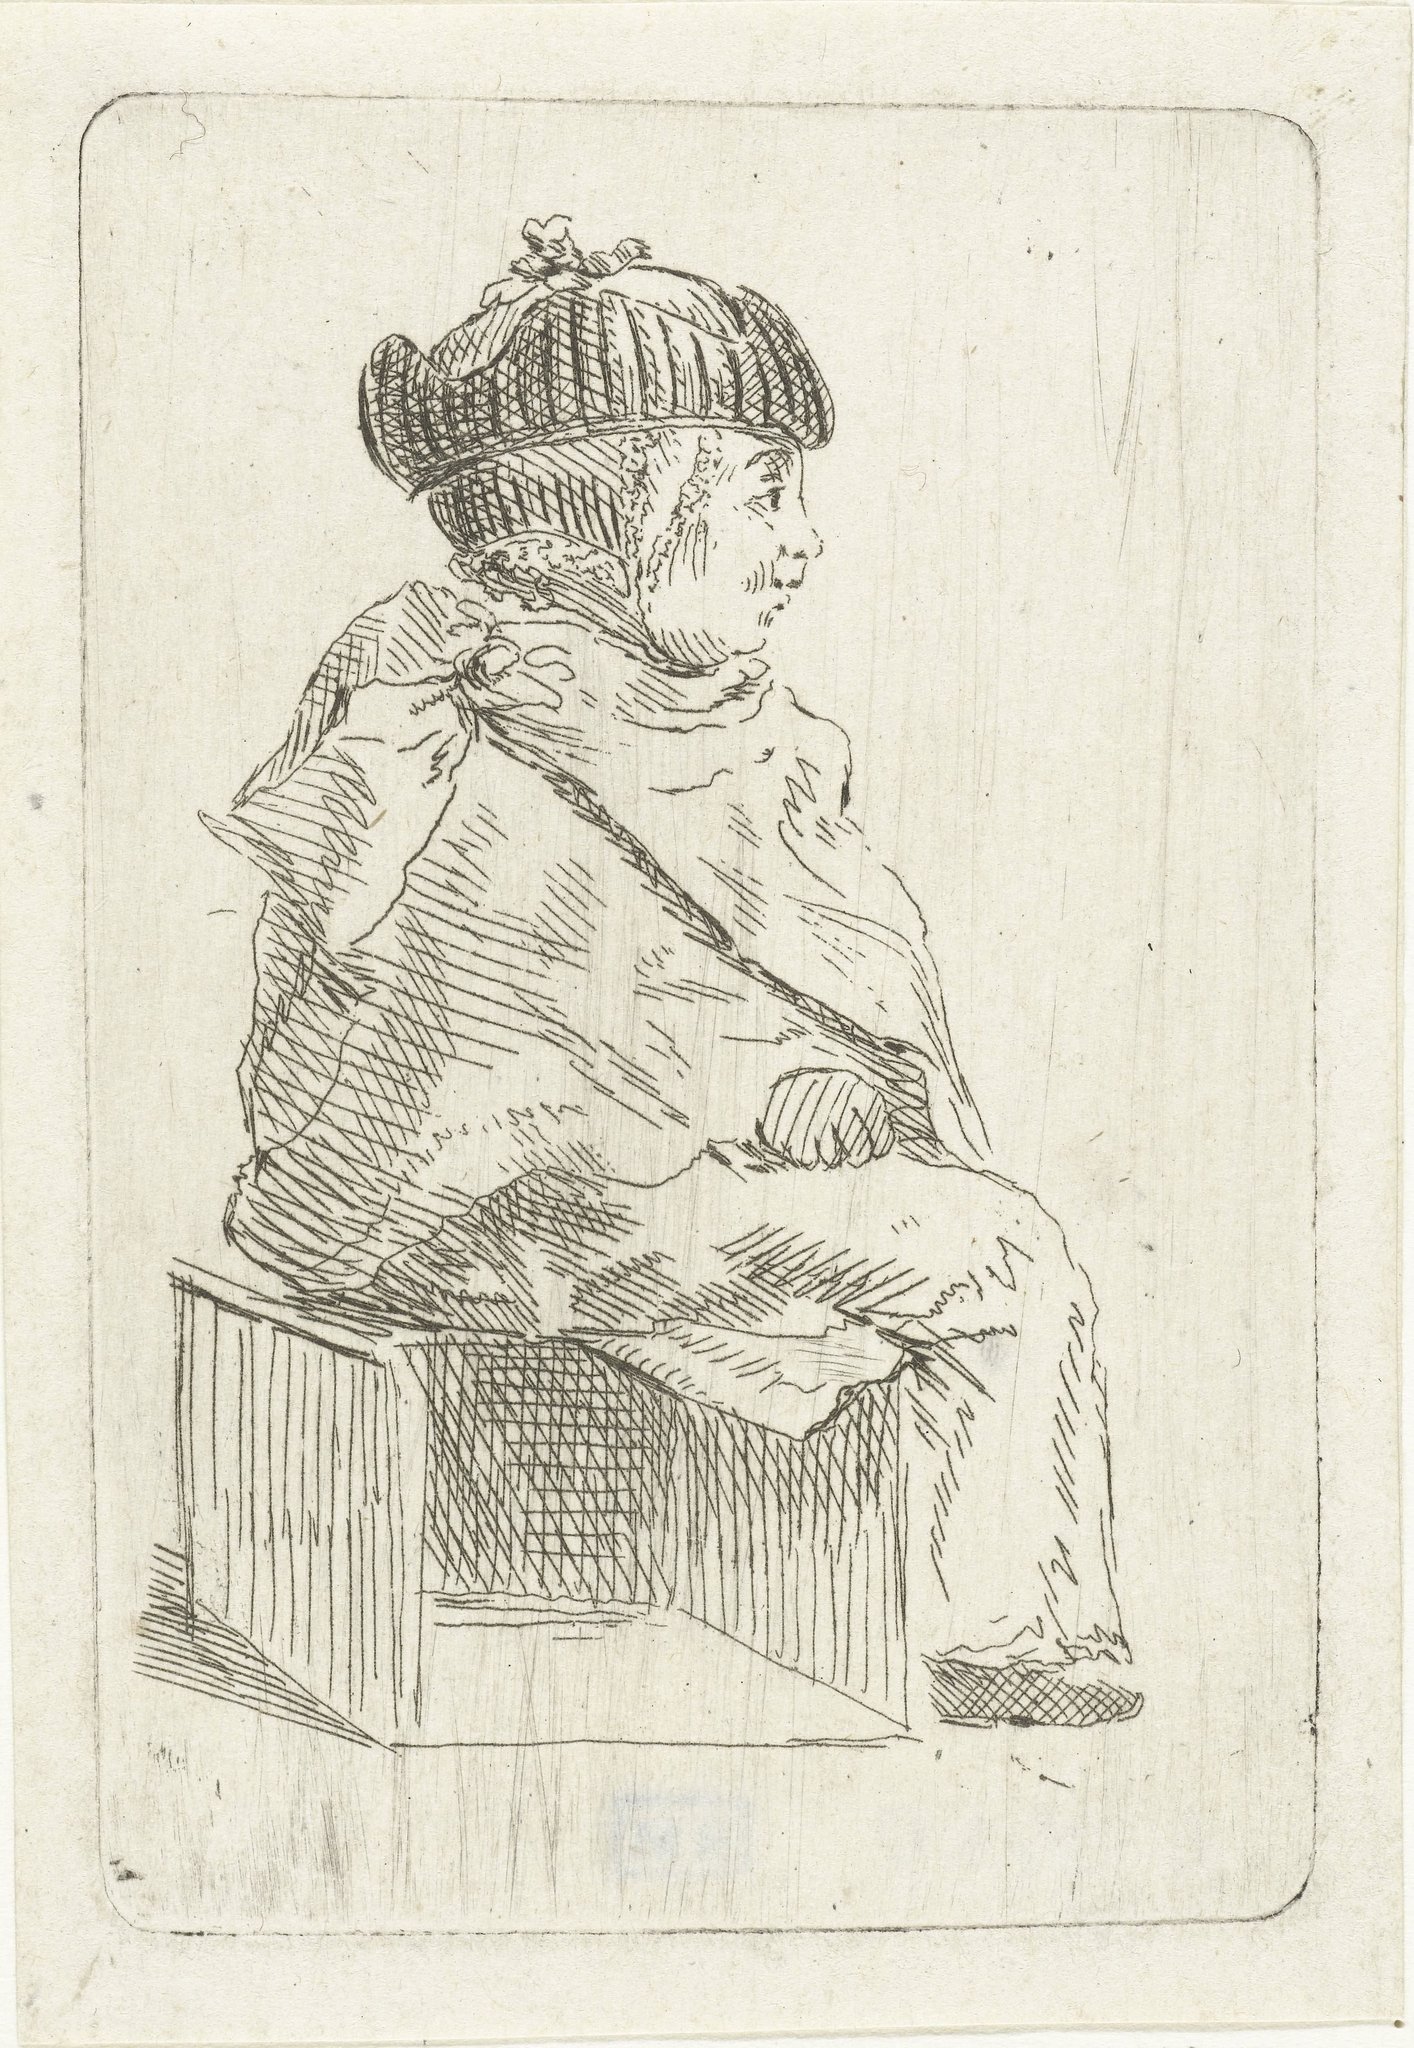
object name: print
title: Kind met valhoed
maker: louis bernard coclers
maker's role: draughtsman, print maker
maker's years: 1741-1817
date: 1756-1817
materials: paper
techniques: etching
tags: head-protector (~ learning to walk)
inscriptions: collector's mark: Lugt 2227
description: Een kind met valhoed zit op een stoof, om de nek heeft het een slab gebonden.